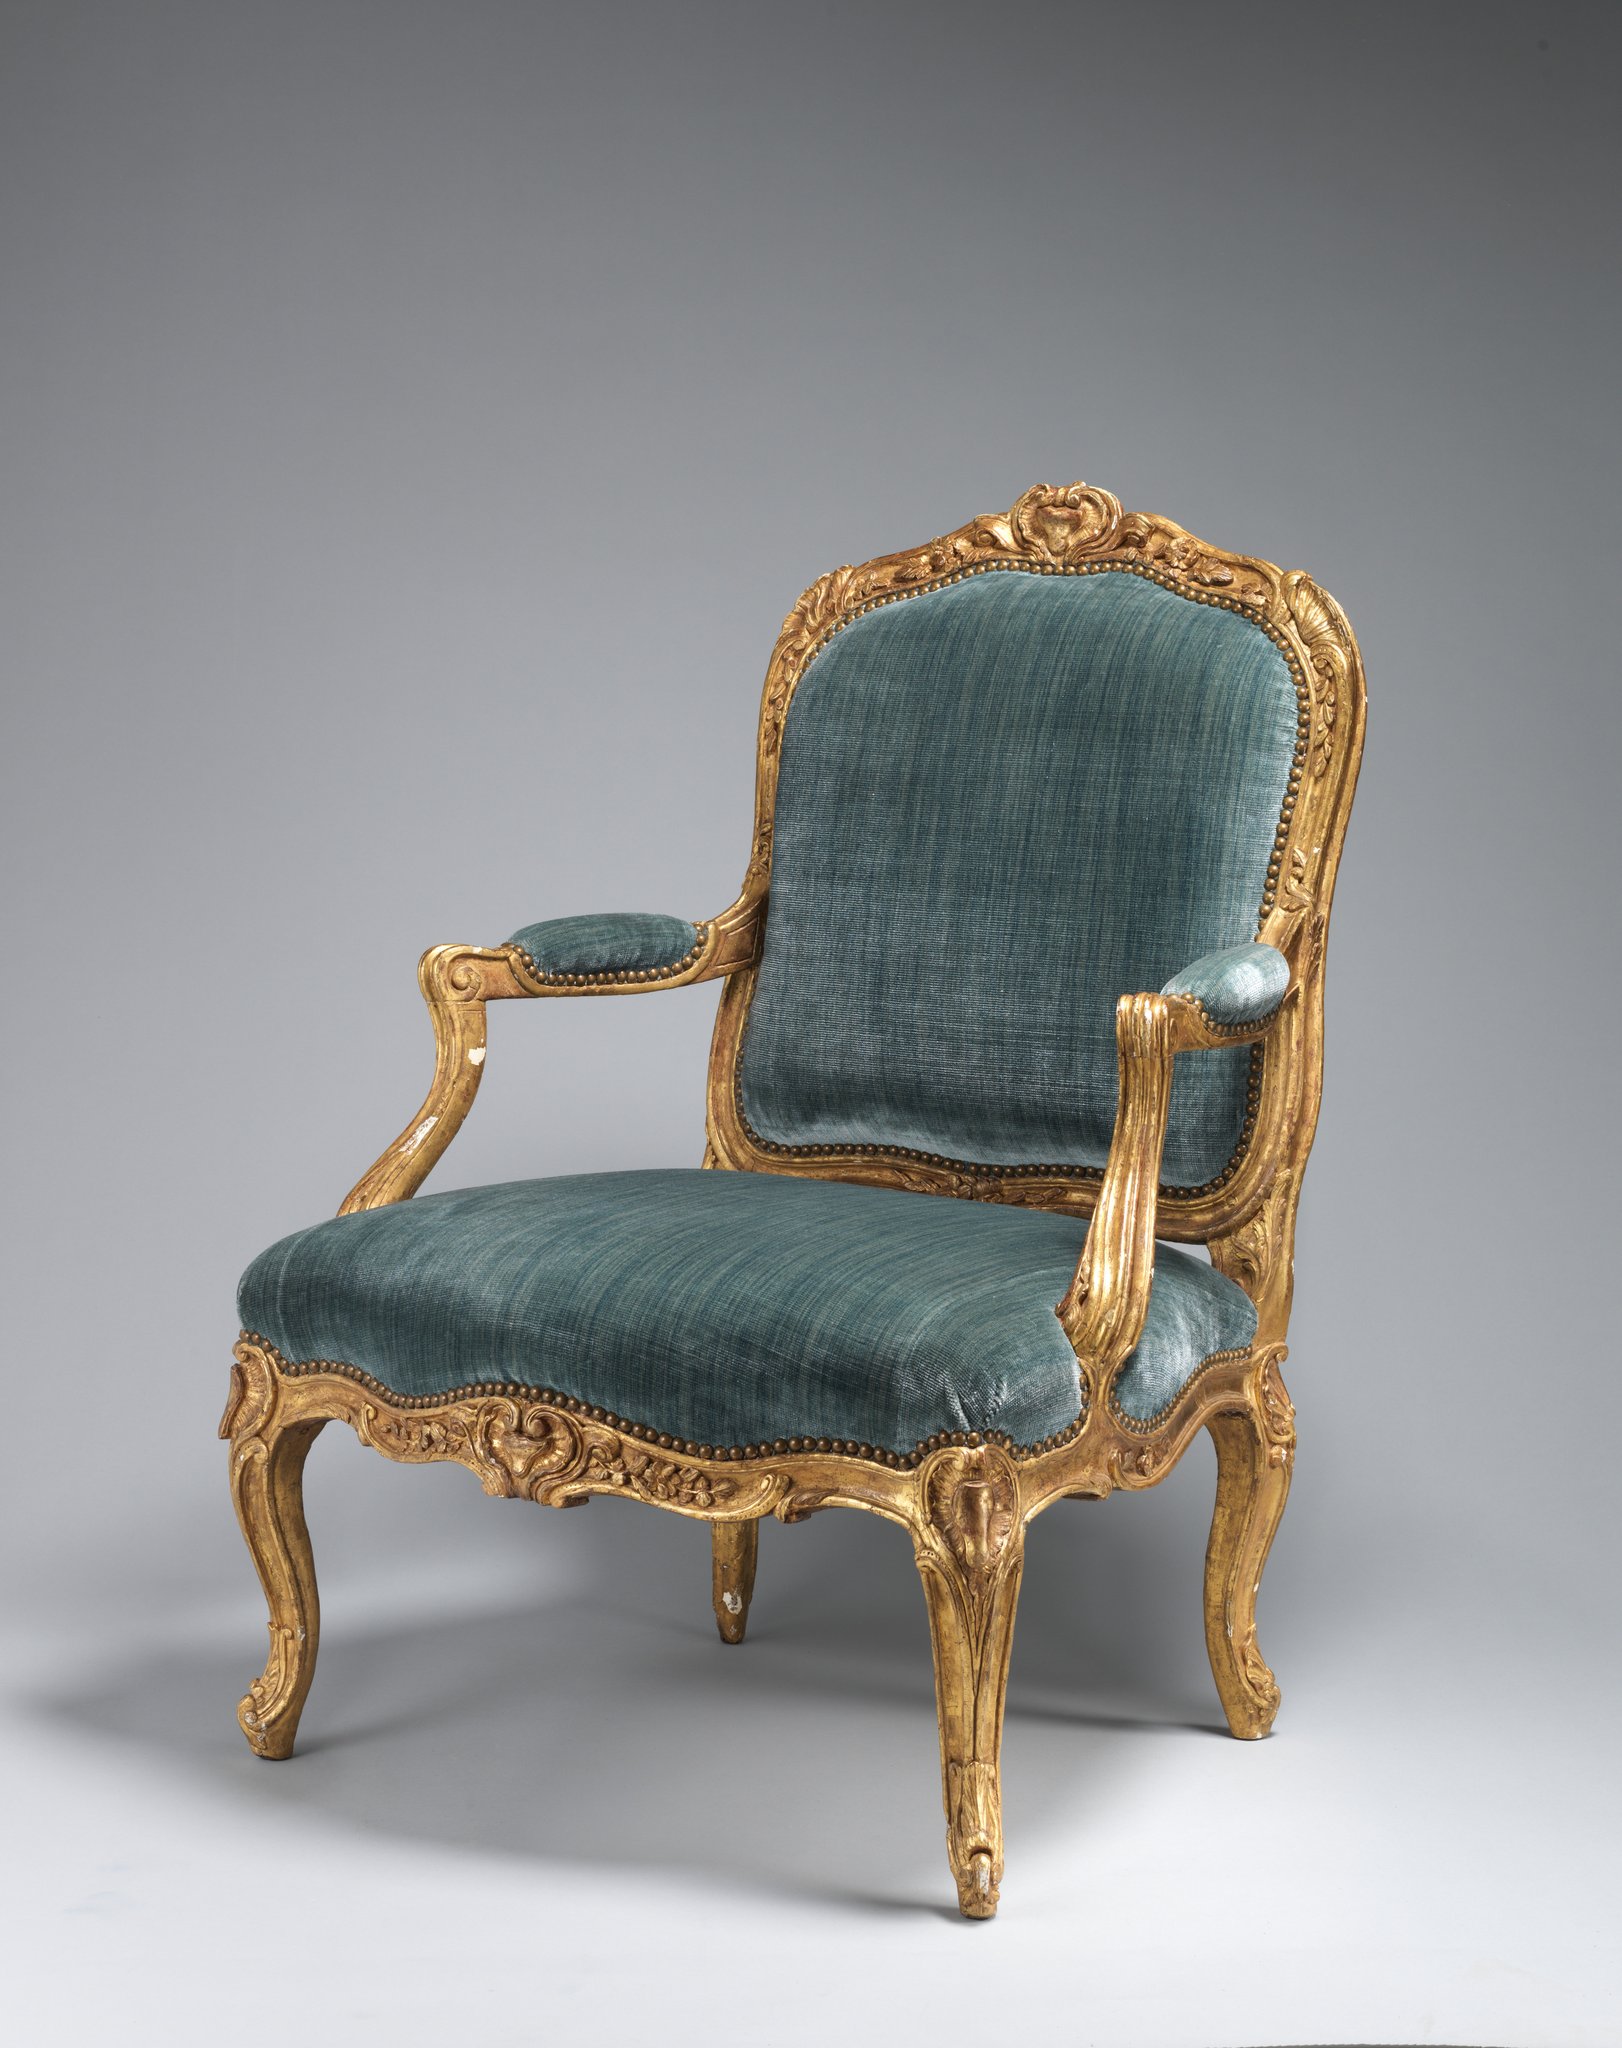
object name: armchair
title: Armchair (fauteuil à la Reine) (one of a pair)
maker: jean-baptiste i tilliard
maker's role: maker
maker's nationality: french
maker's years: 1686-1766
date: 1701-1800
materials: wood, velvet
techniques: carving, gilding